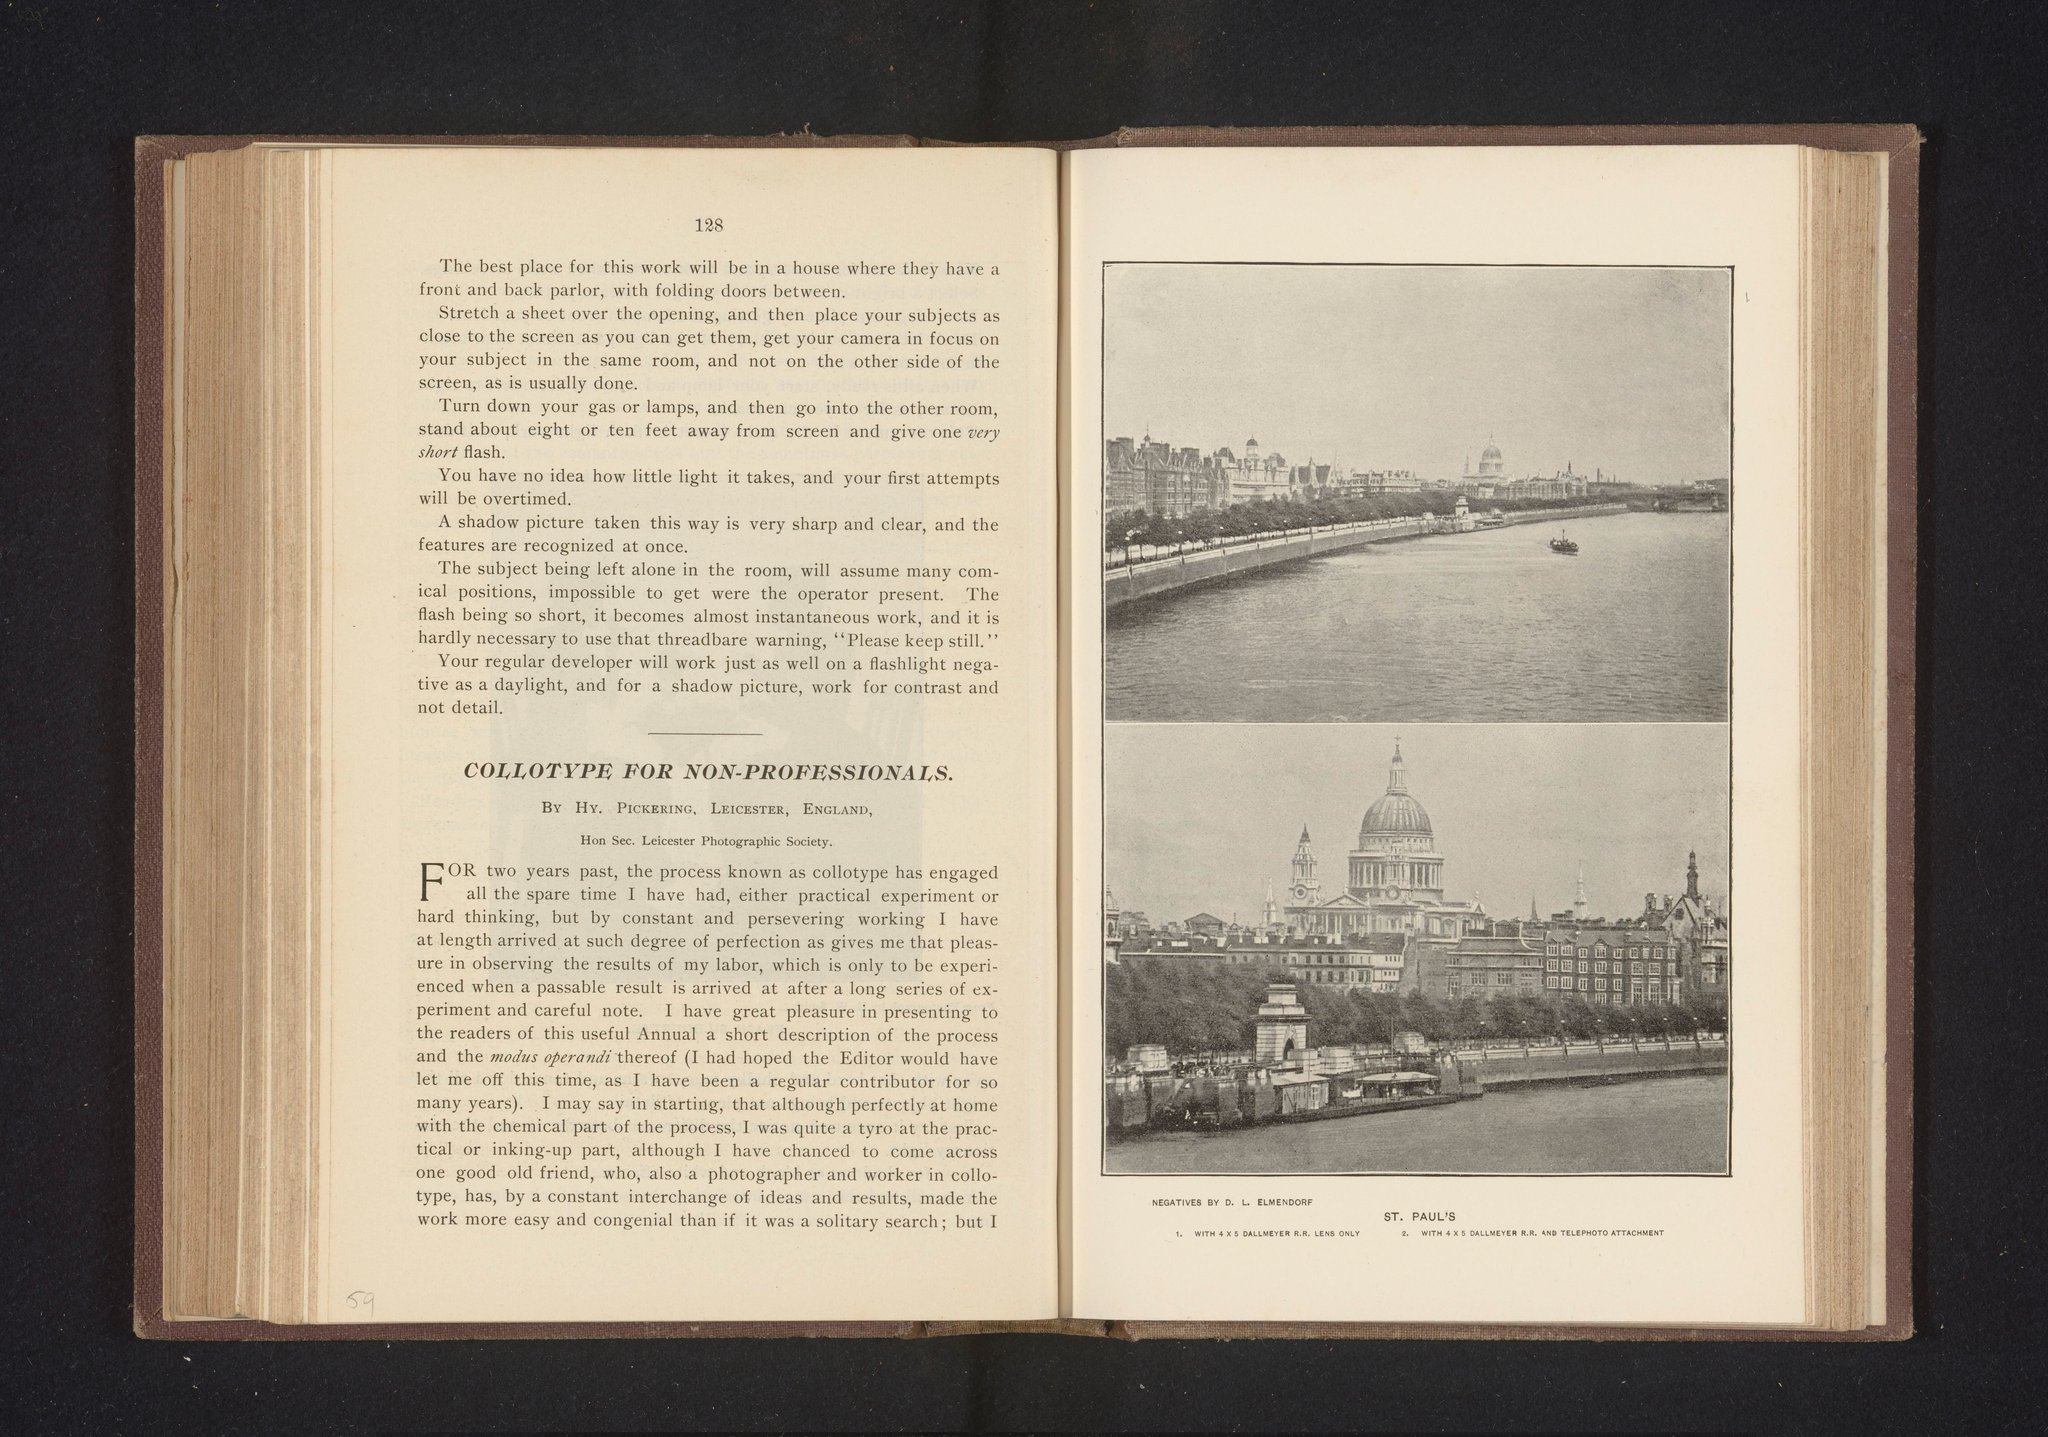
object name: photomechanical print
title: St. Paul's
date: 1890-1895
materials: paper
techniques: autotype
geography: london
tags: church (exterior), façade (of house or building)